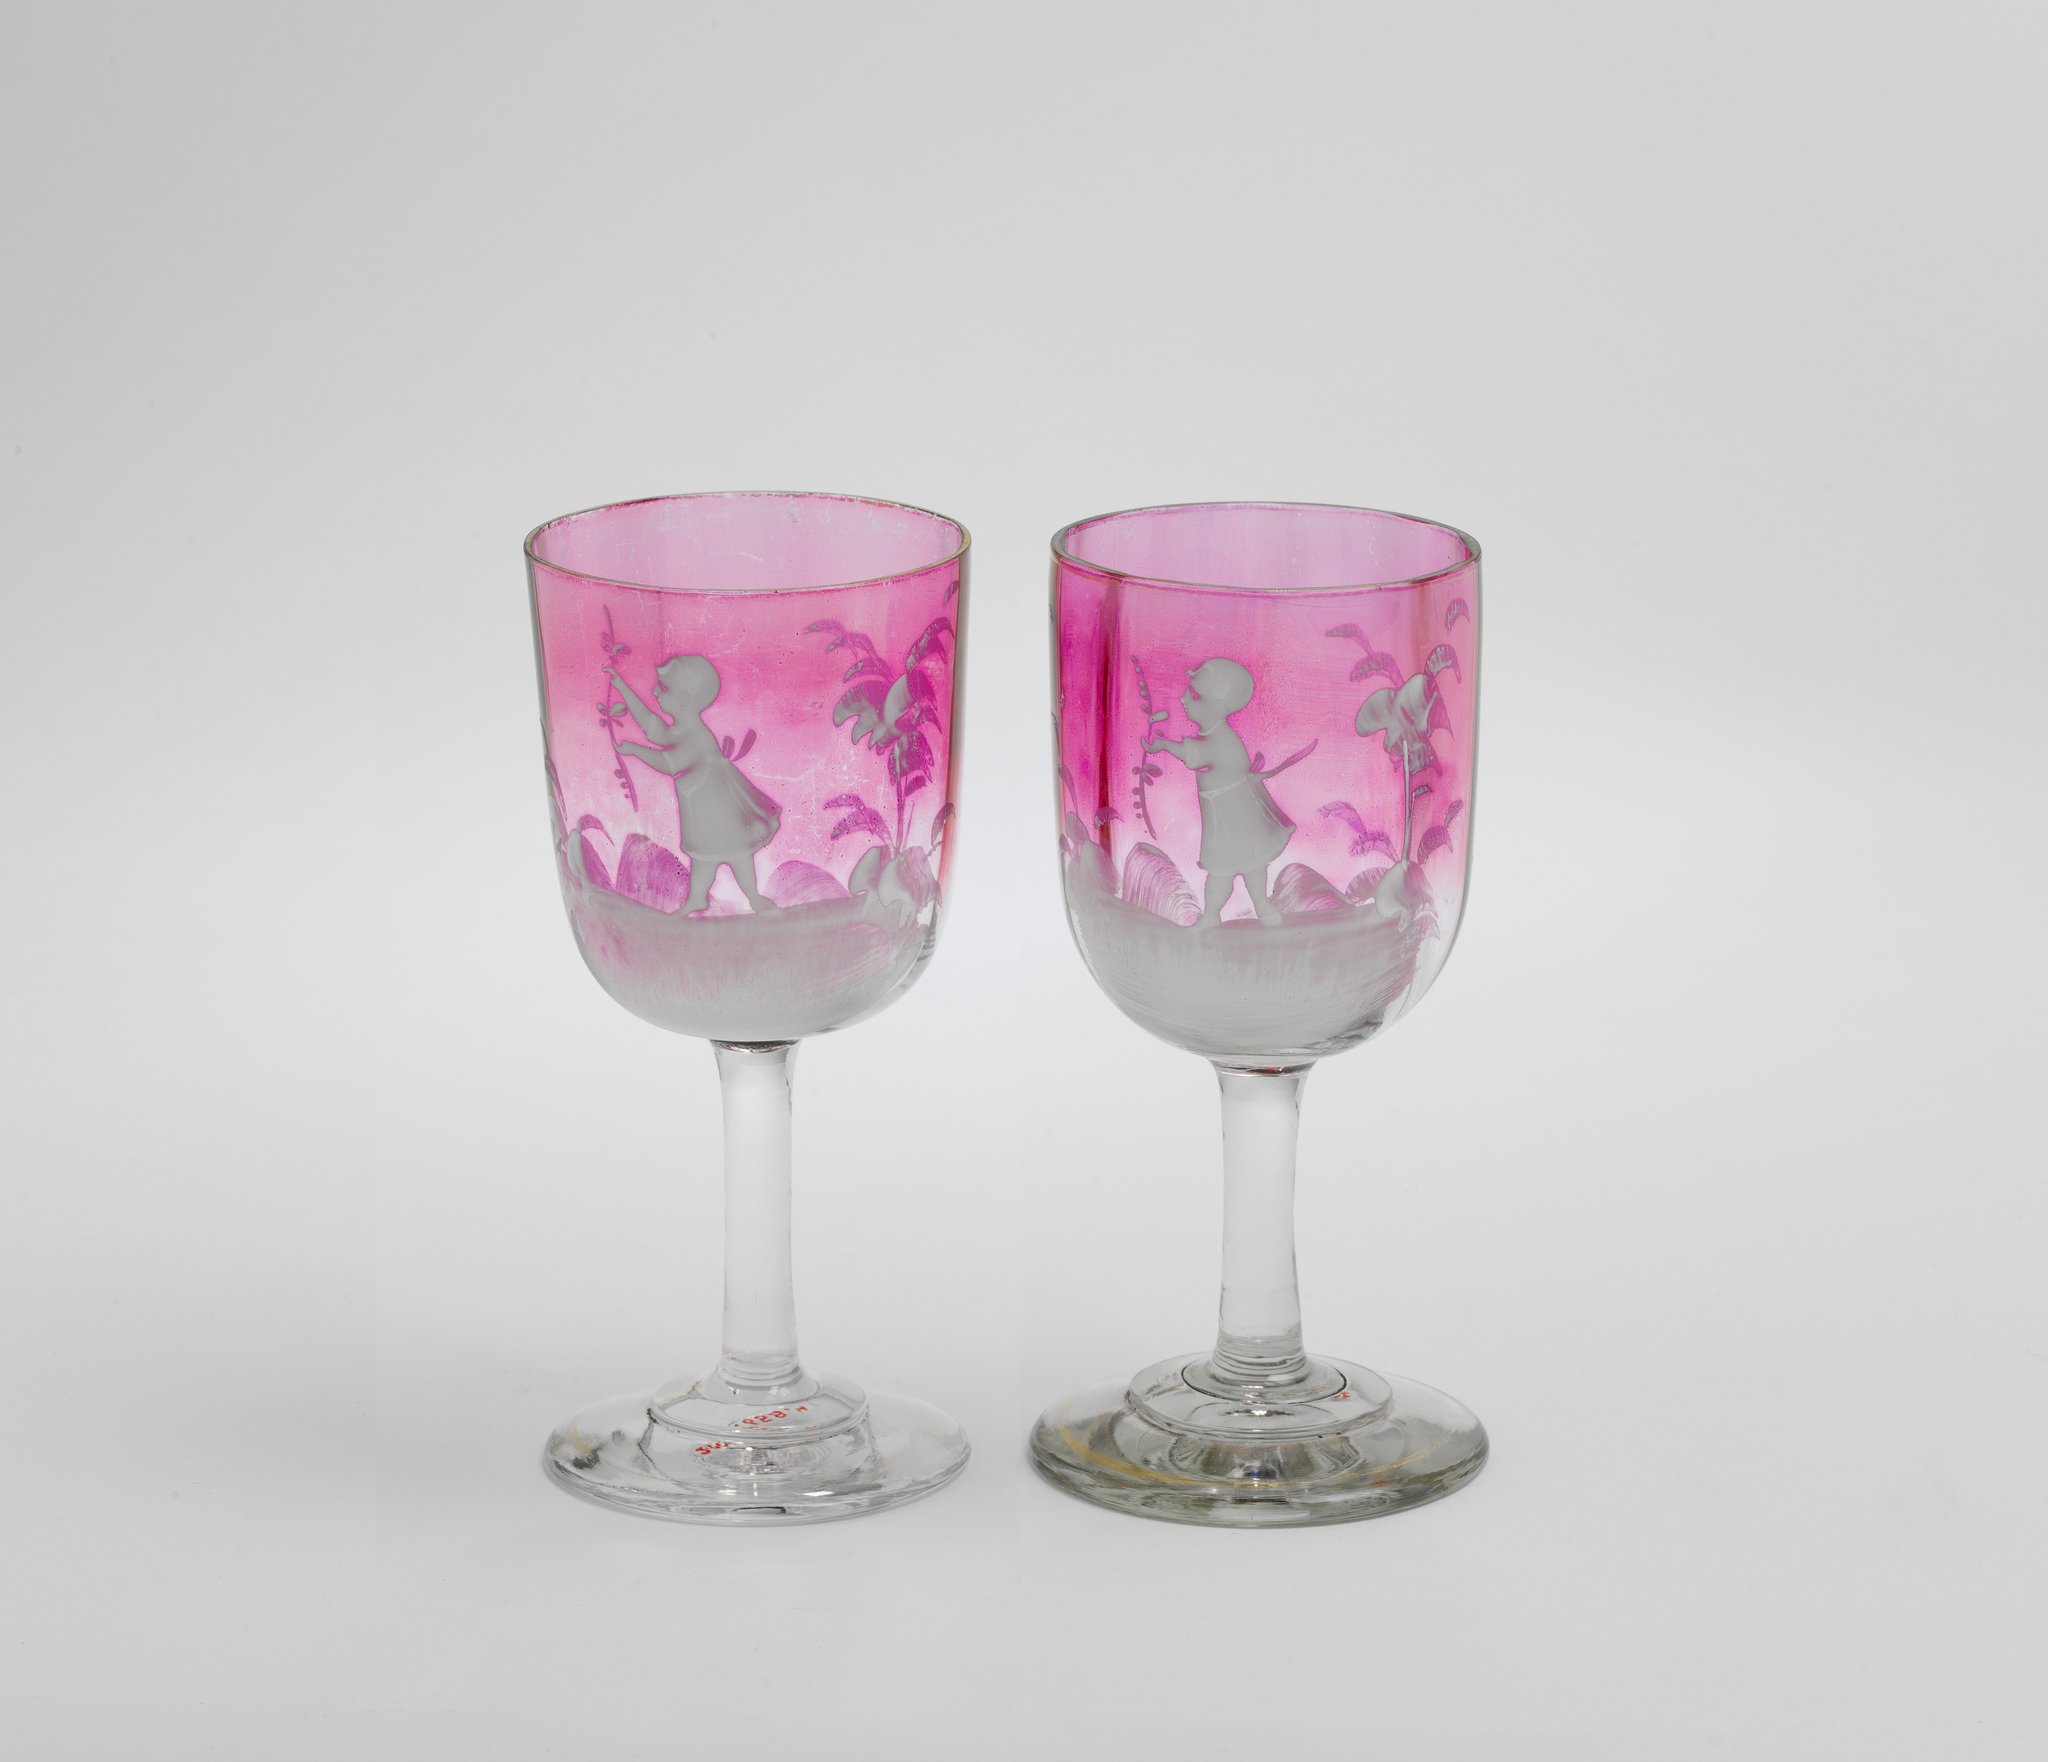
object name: liqueur glass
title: Liqueur glasses (part of a set)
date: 1867-1900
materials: enamel, gilt, glass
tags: girls